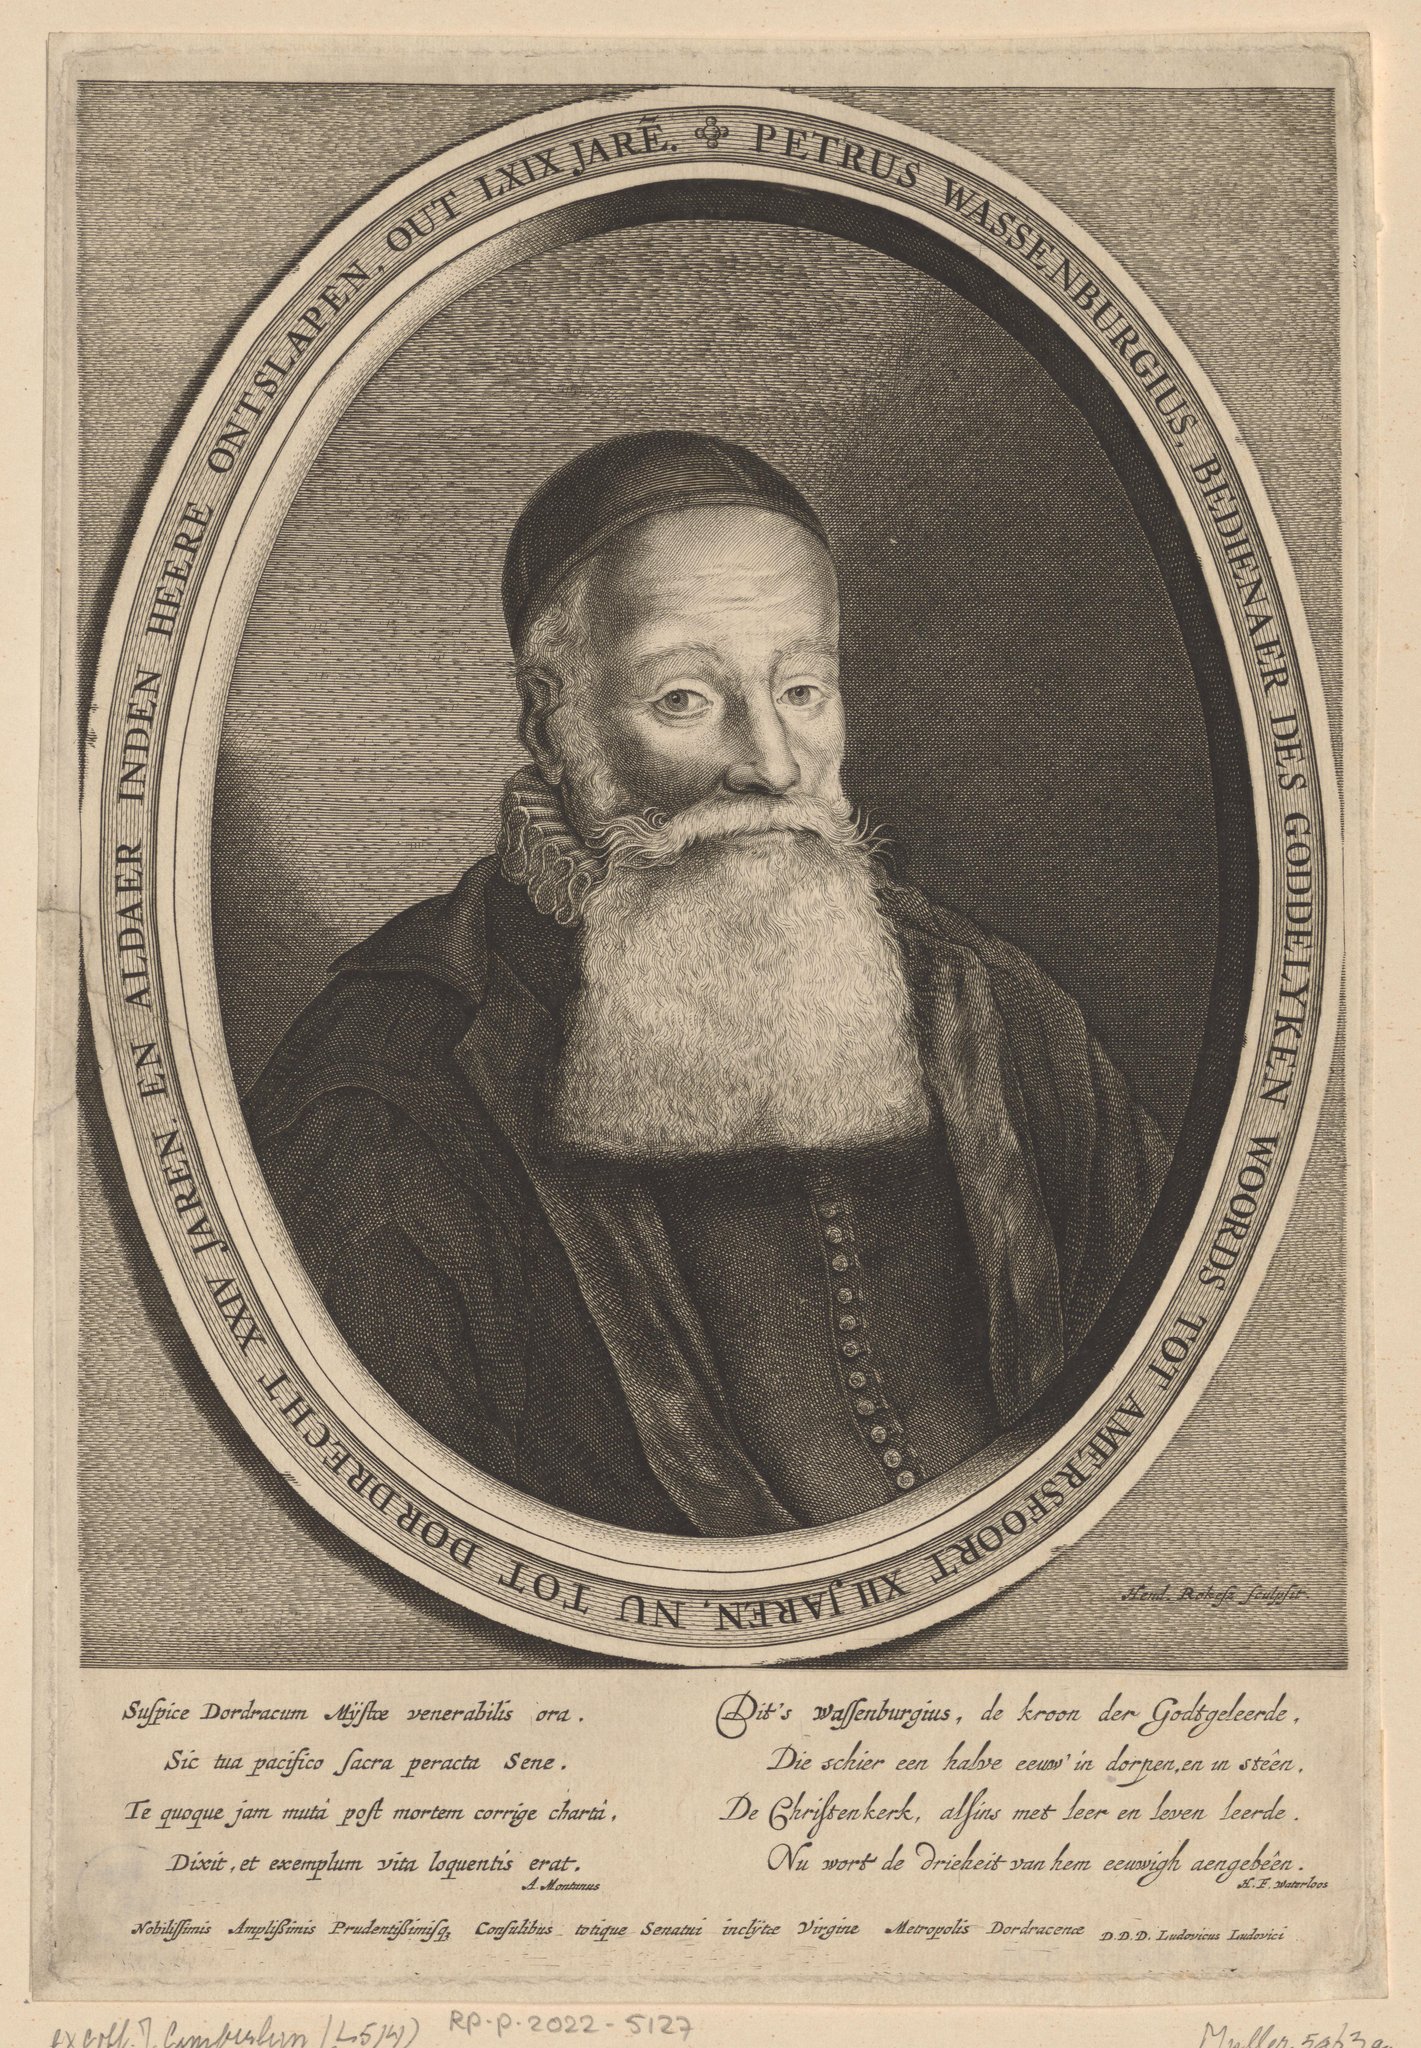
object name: print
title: Portret van Petrus Wassenburgh op 69-jarige leeftijd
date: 1655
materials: paper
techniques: engraving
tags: dordrecht, functionaries and dignitaries (with name) ~ protestant churches, historical persons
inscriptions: collector's mark: Lugt 514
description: Onder het portret een vierregelig vers in het Latijn en een vierregelig vers in het Nederlands, in twee kolommen.